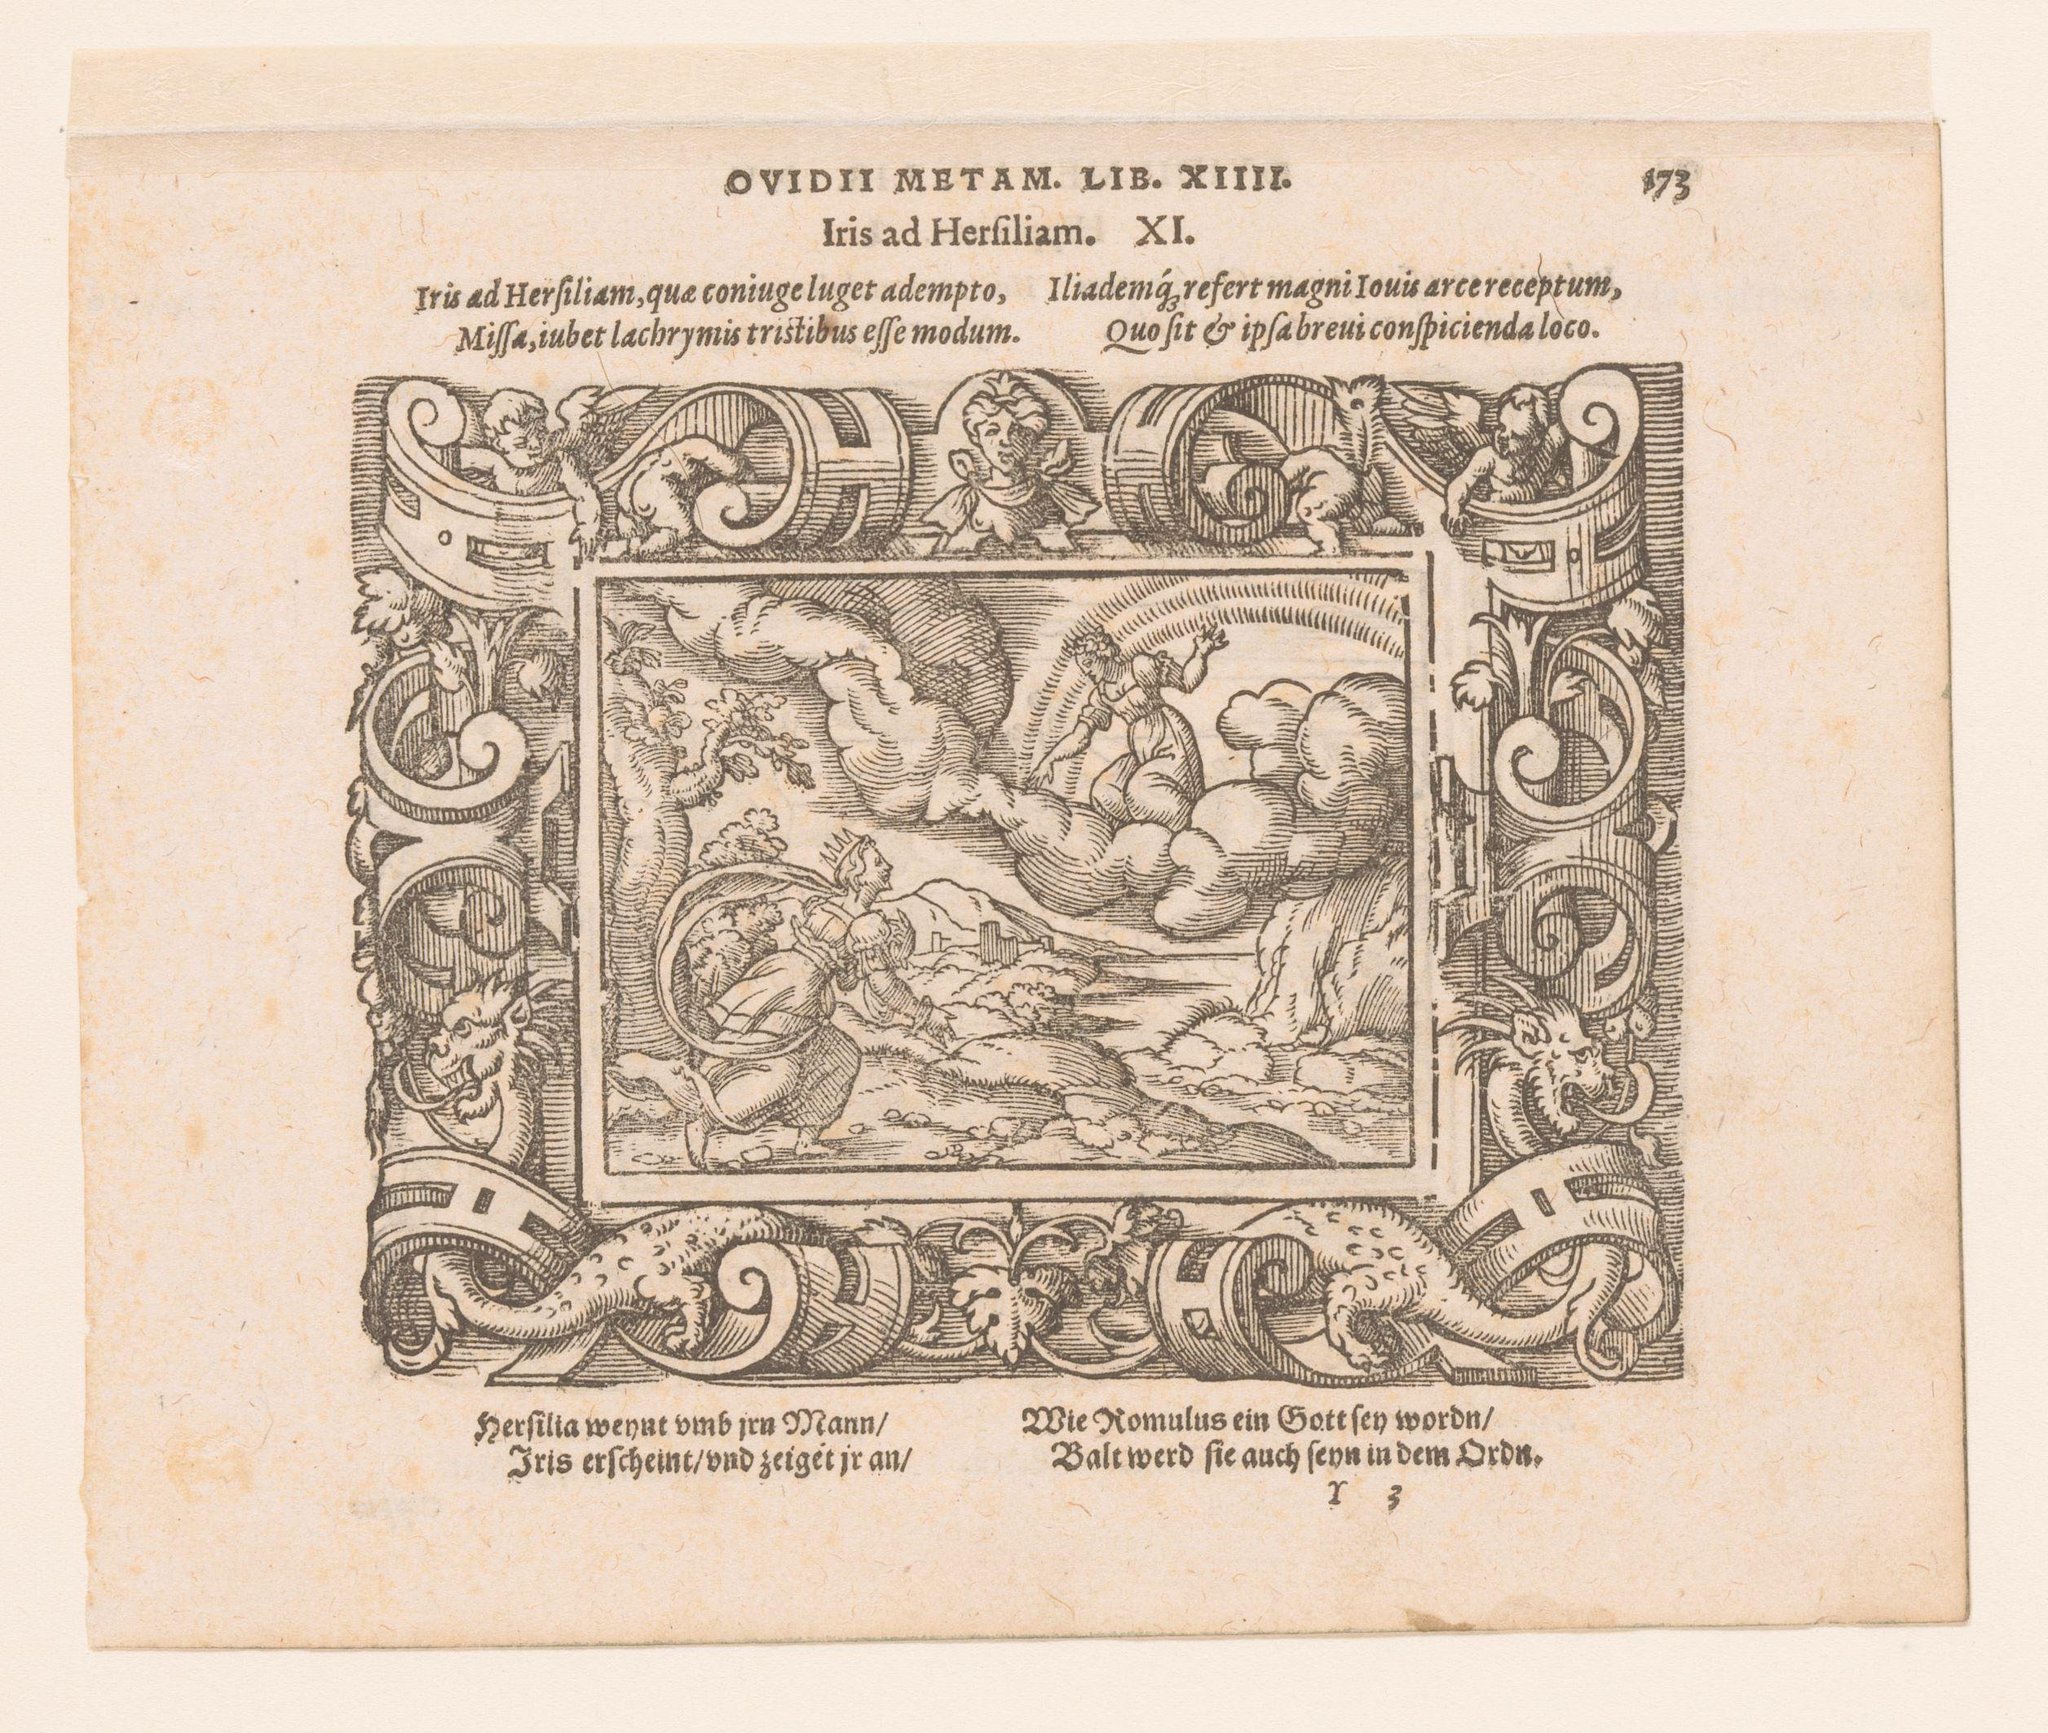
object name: book illustration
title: Iris ad Hersiliam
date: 1569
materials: paper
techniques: letterpress printing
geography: nuremberg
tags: apotheosis of hersilia: the wife of romulus is taken up to heaven by juno and isis, and becomes the goddess hora quirina, scrollwork, strapwork ~ ornament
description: Illustratie bij de Metamorfosen van Ovidius, afkomstig uit de publicatie: Posthius, Johannes. Tetrasticha in Ovidii metam. Frankfurt am Main: Georg Rab en Sigmund Feyerabend en erven Weigand Han, 1569. De voorstellingen en ornamentranden van deze boekillustraties zijn van twee aparte blokken gedrukt. Beide werden afzonderlijk van elkaar ook gebruikt voor andere publicaties, en de ornamentranden werden eveneens binnen deze publicatie meerdere keren gebruikt.